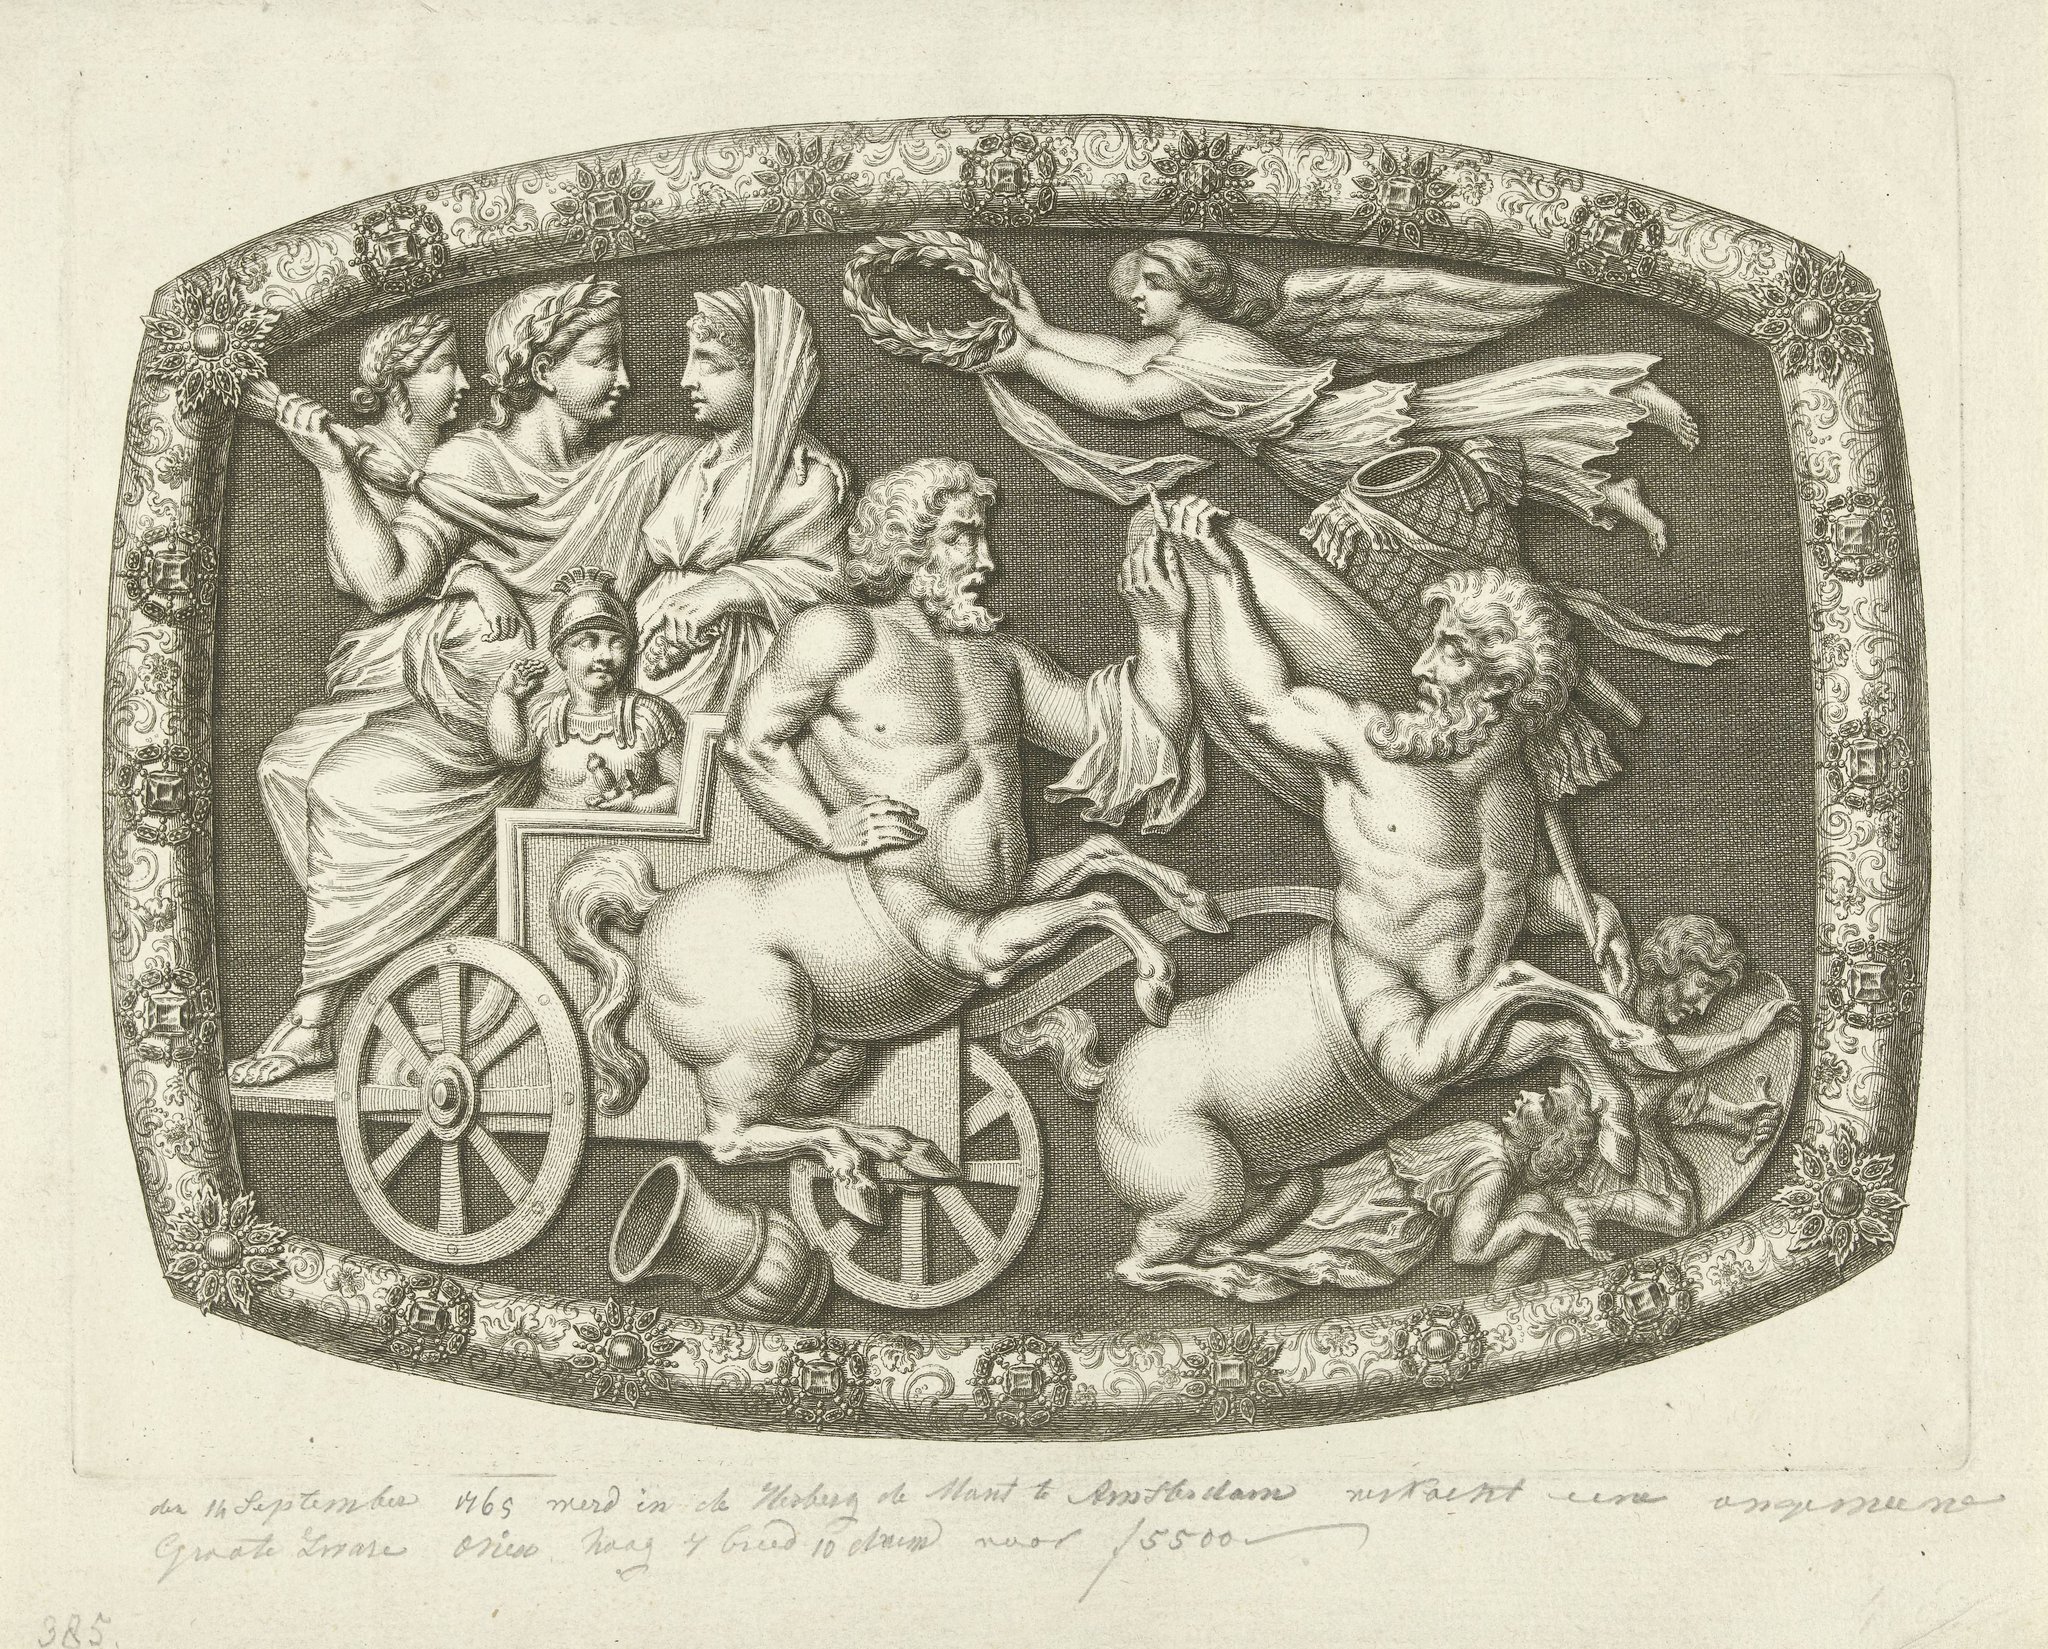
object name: print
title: Onyx met een Romeinse praalwagen en twee centauren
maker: simon fokke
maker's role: draughtsman, print maker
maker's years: 1712-1784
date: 1765-1767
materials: paper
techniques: engraving, etching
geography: amsterdam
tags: centaurs, chariot, triumphal car, ornaments, jewels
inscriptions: caption: ‘den 11 September 1765 werd in de Herberg de Munt te Amsterdam verkocht eene ... onix ... voor f. 5500’, collector's mark: Lugt 2228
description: Een onyx met de beeltenis van een Romeinse praalwagen waarop een gelauwerde man met vrouw en kind zit. Voor de kar lopen twee centauren, in de lucht vliegt een engel met een lauwerkrans. Rond de onyx een rijk versierde lijst. De onyx zou op 11 september 1765 in de Munt te Amsterdam worden verkocht.